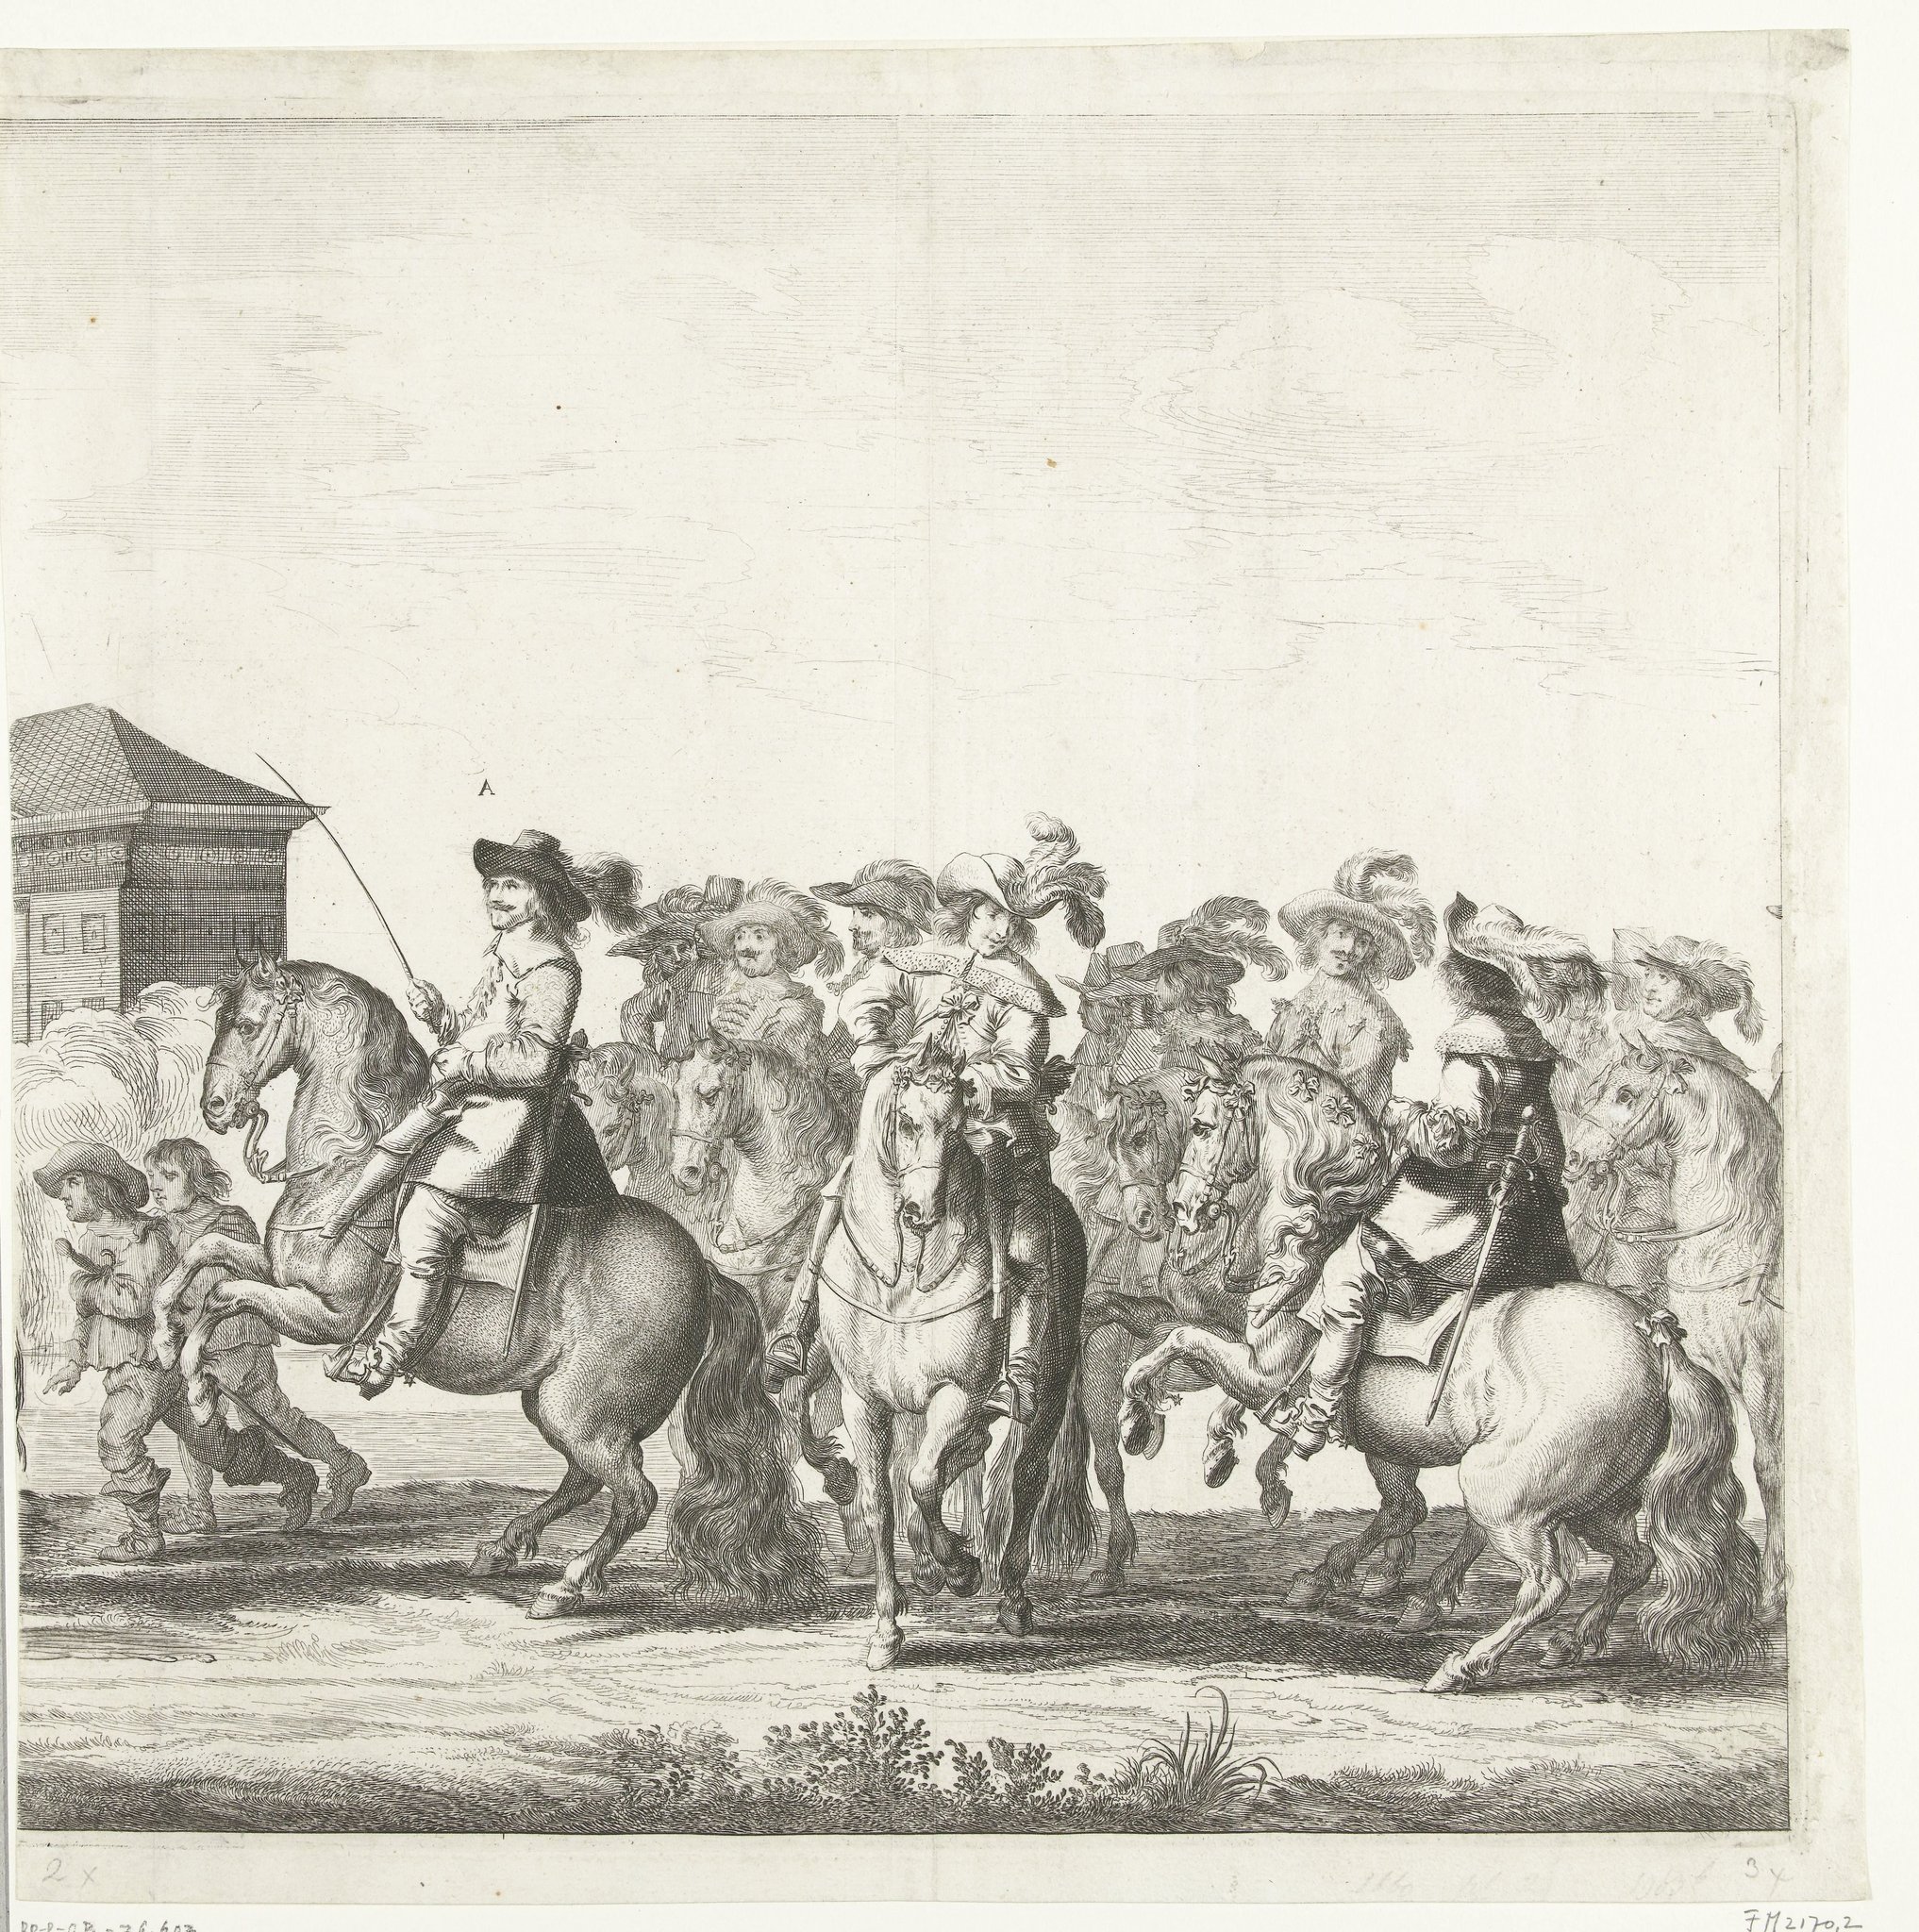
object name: print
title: Intocht van Maria Henrietta Stuart, prinses van Oranje te Amsterdam (plaat 2), 1660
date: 1638-1639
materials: paper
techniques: engraving, etching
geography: northern netherlands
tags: william iii (prince of orange and king of england, scotland, and ireland), the hague, amalia of solms-braunfels, london, mary henrietta stuart, triumphal entry and public reception, pageant, 'entrée solennelle', 'joyeuse entrée'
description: Bezoek van de Maria Henrietta Stuart, prinses van Oranje, vergezeld door Amalia van Solms, de jonge prins Willem III en anderen te Amsterdam, 15 juni 1660. De aankomst van de stoet met ruiters bij de Haarlemmerpoort. De voorste ruiter gemerkt met de letter A. Tweede plaat in een ongemonteerd ensemble bestaande uit een zeven bladen van de stoet.